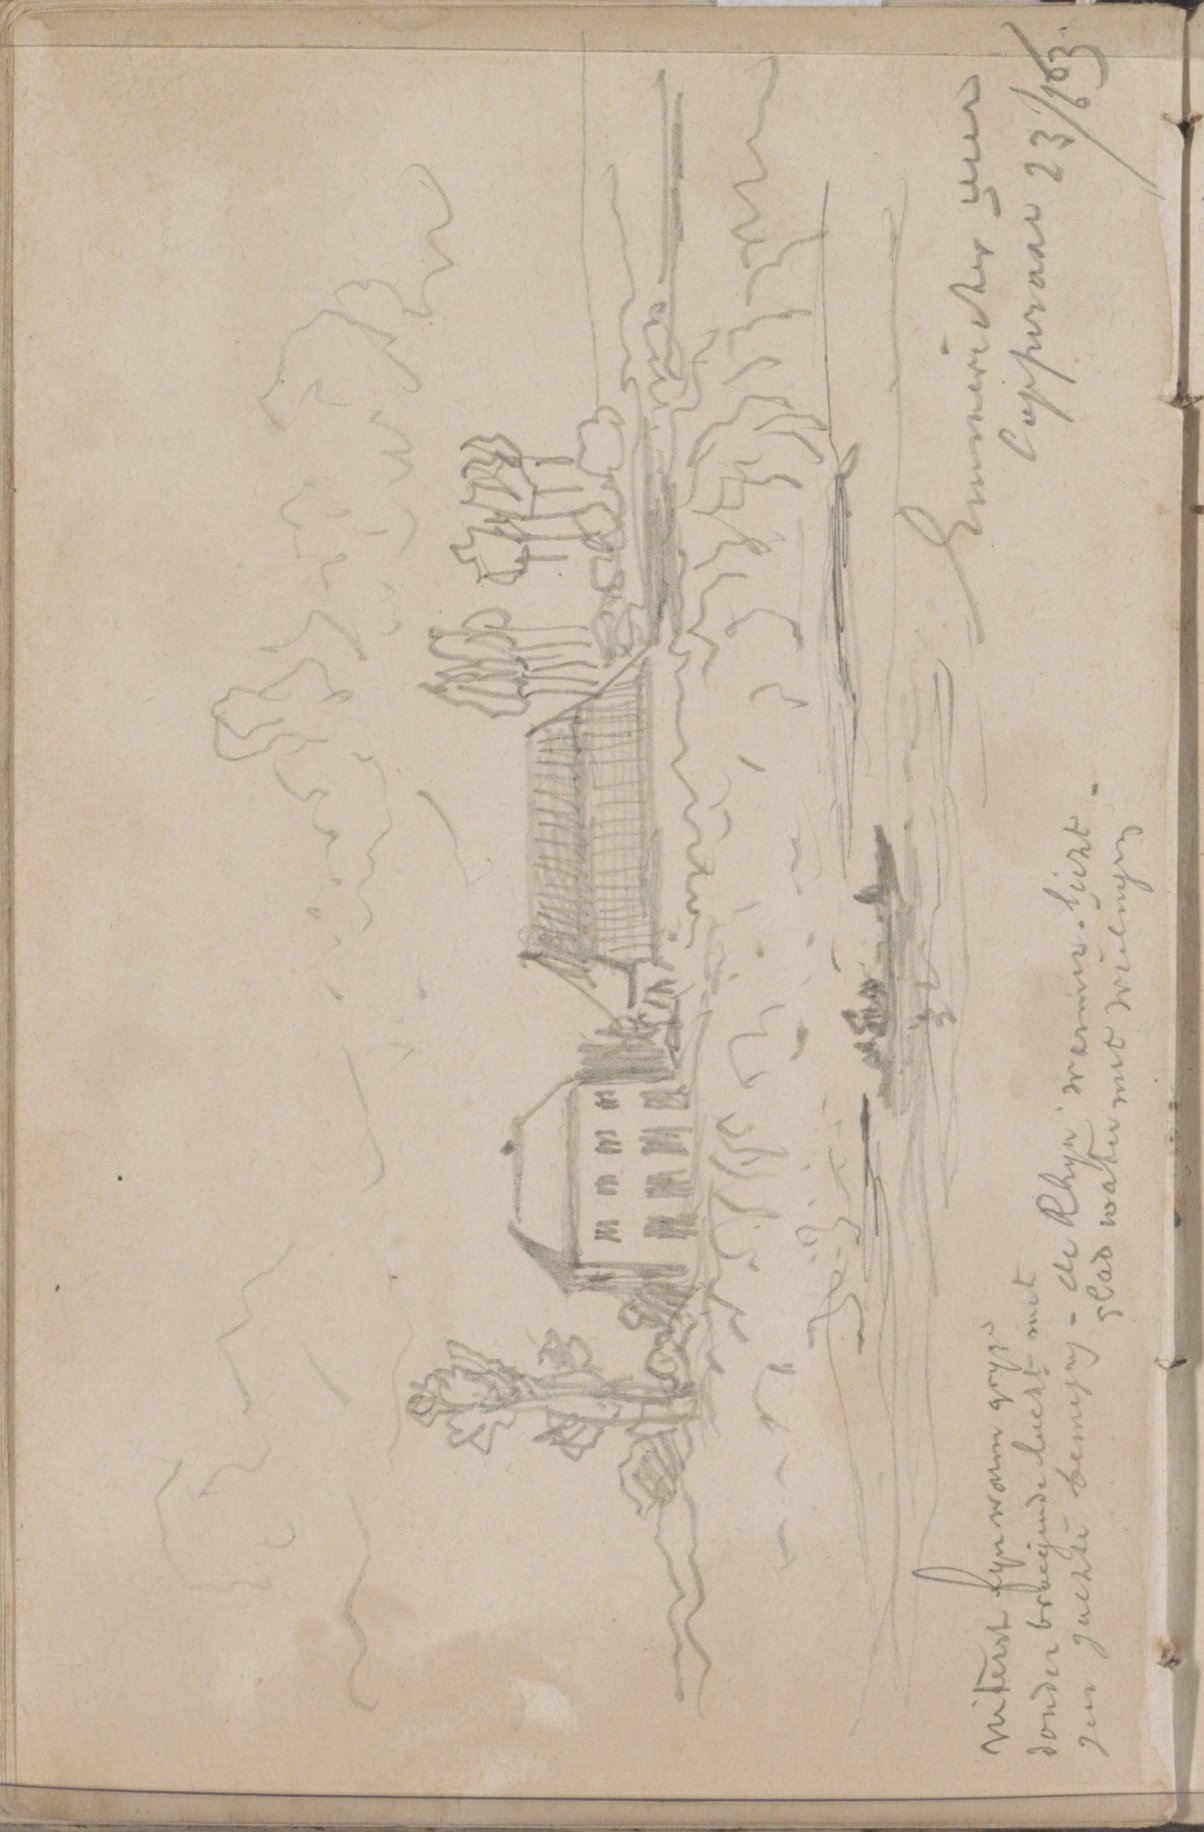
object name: sketchbook leaf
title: Emmerik aan de Rijn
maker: johannes tavenraat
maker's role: draughtsman, painter, print maker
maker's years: 1809-1881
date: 1806-1863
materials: paper, pencil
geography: emmerik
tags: city-view, and landscape with man-made constructions, river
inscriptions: date and inscription: ‘Emmerik [...] 23/6 63’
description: Blad 40 verso uit een schetsboek met 65 bladen.